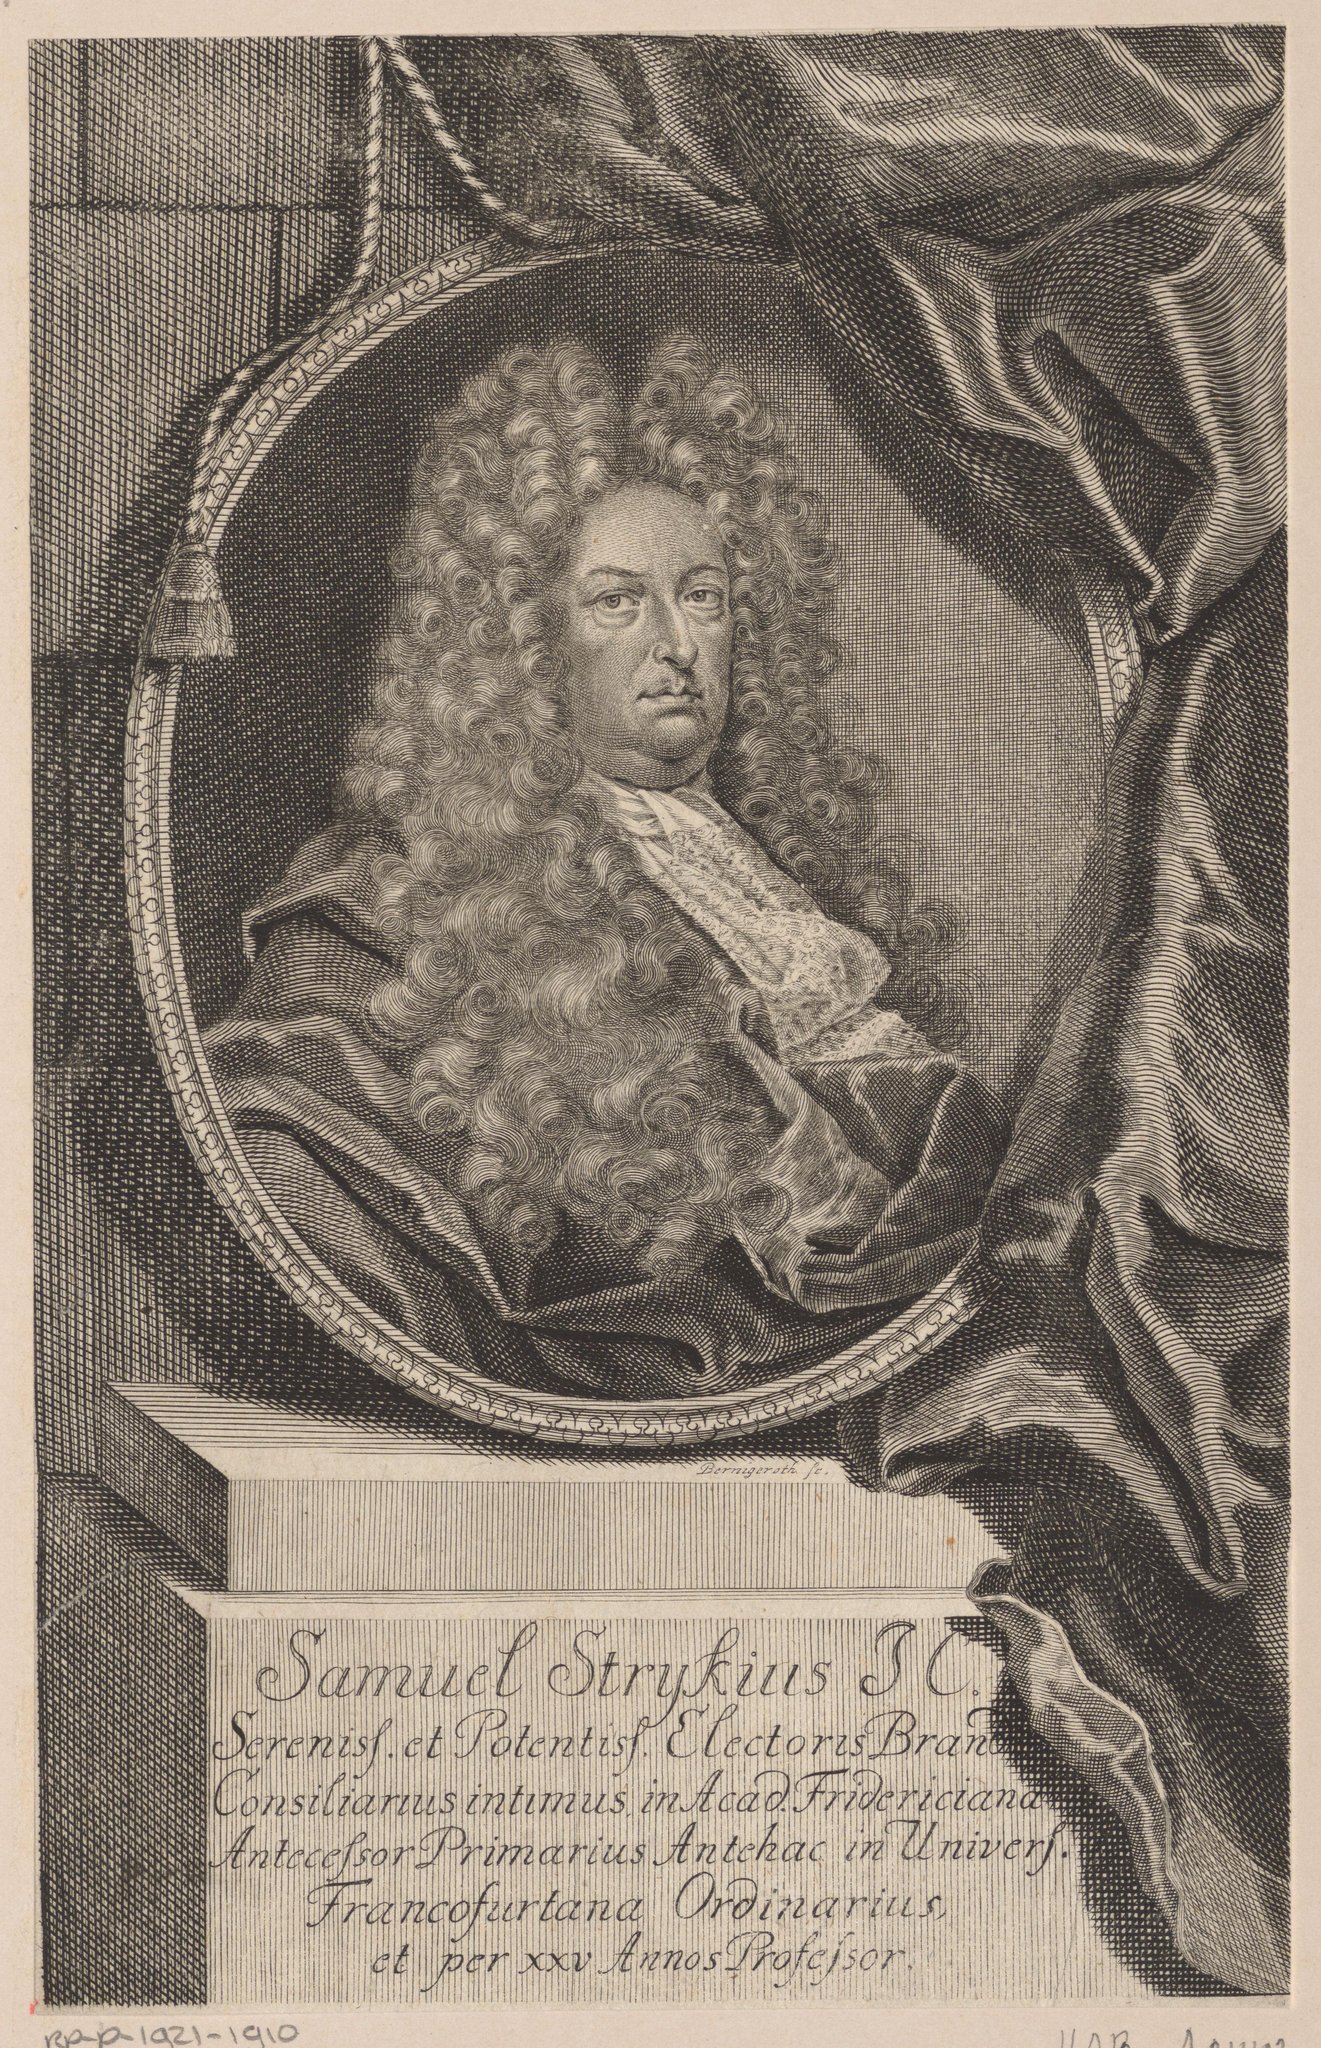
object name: print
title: Portret van Samuel Stryk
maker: martin bernigeroth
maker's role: print maker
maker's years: 1670-1733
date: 1707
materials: paper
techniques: engraving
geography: germany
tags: samuel stryk, historical persons, lawyer, attorney at law, professor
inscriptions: collector's mark: Lugt 2233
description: Prent ook gebruikt in: Beckmann, Johann Christoph. Notitia Universitatis Francofurtanae (...). Frankfurt an der Oder: erven Jeremias Schrey en Johann Christoph Hartmann, 1707, p. 224.